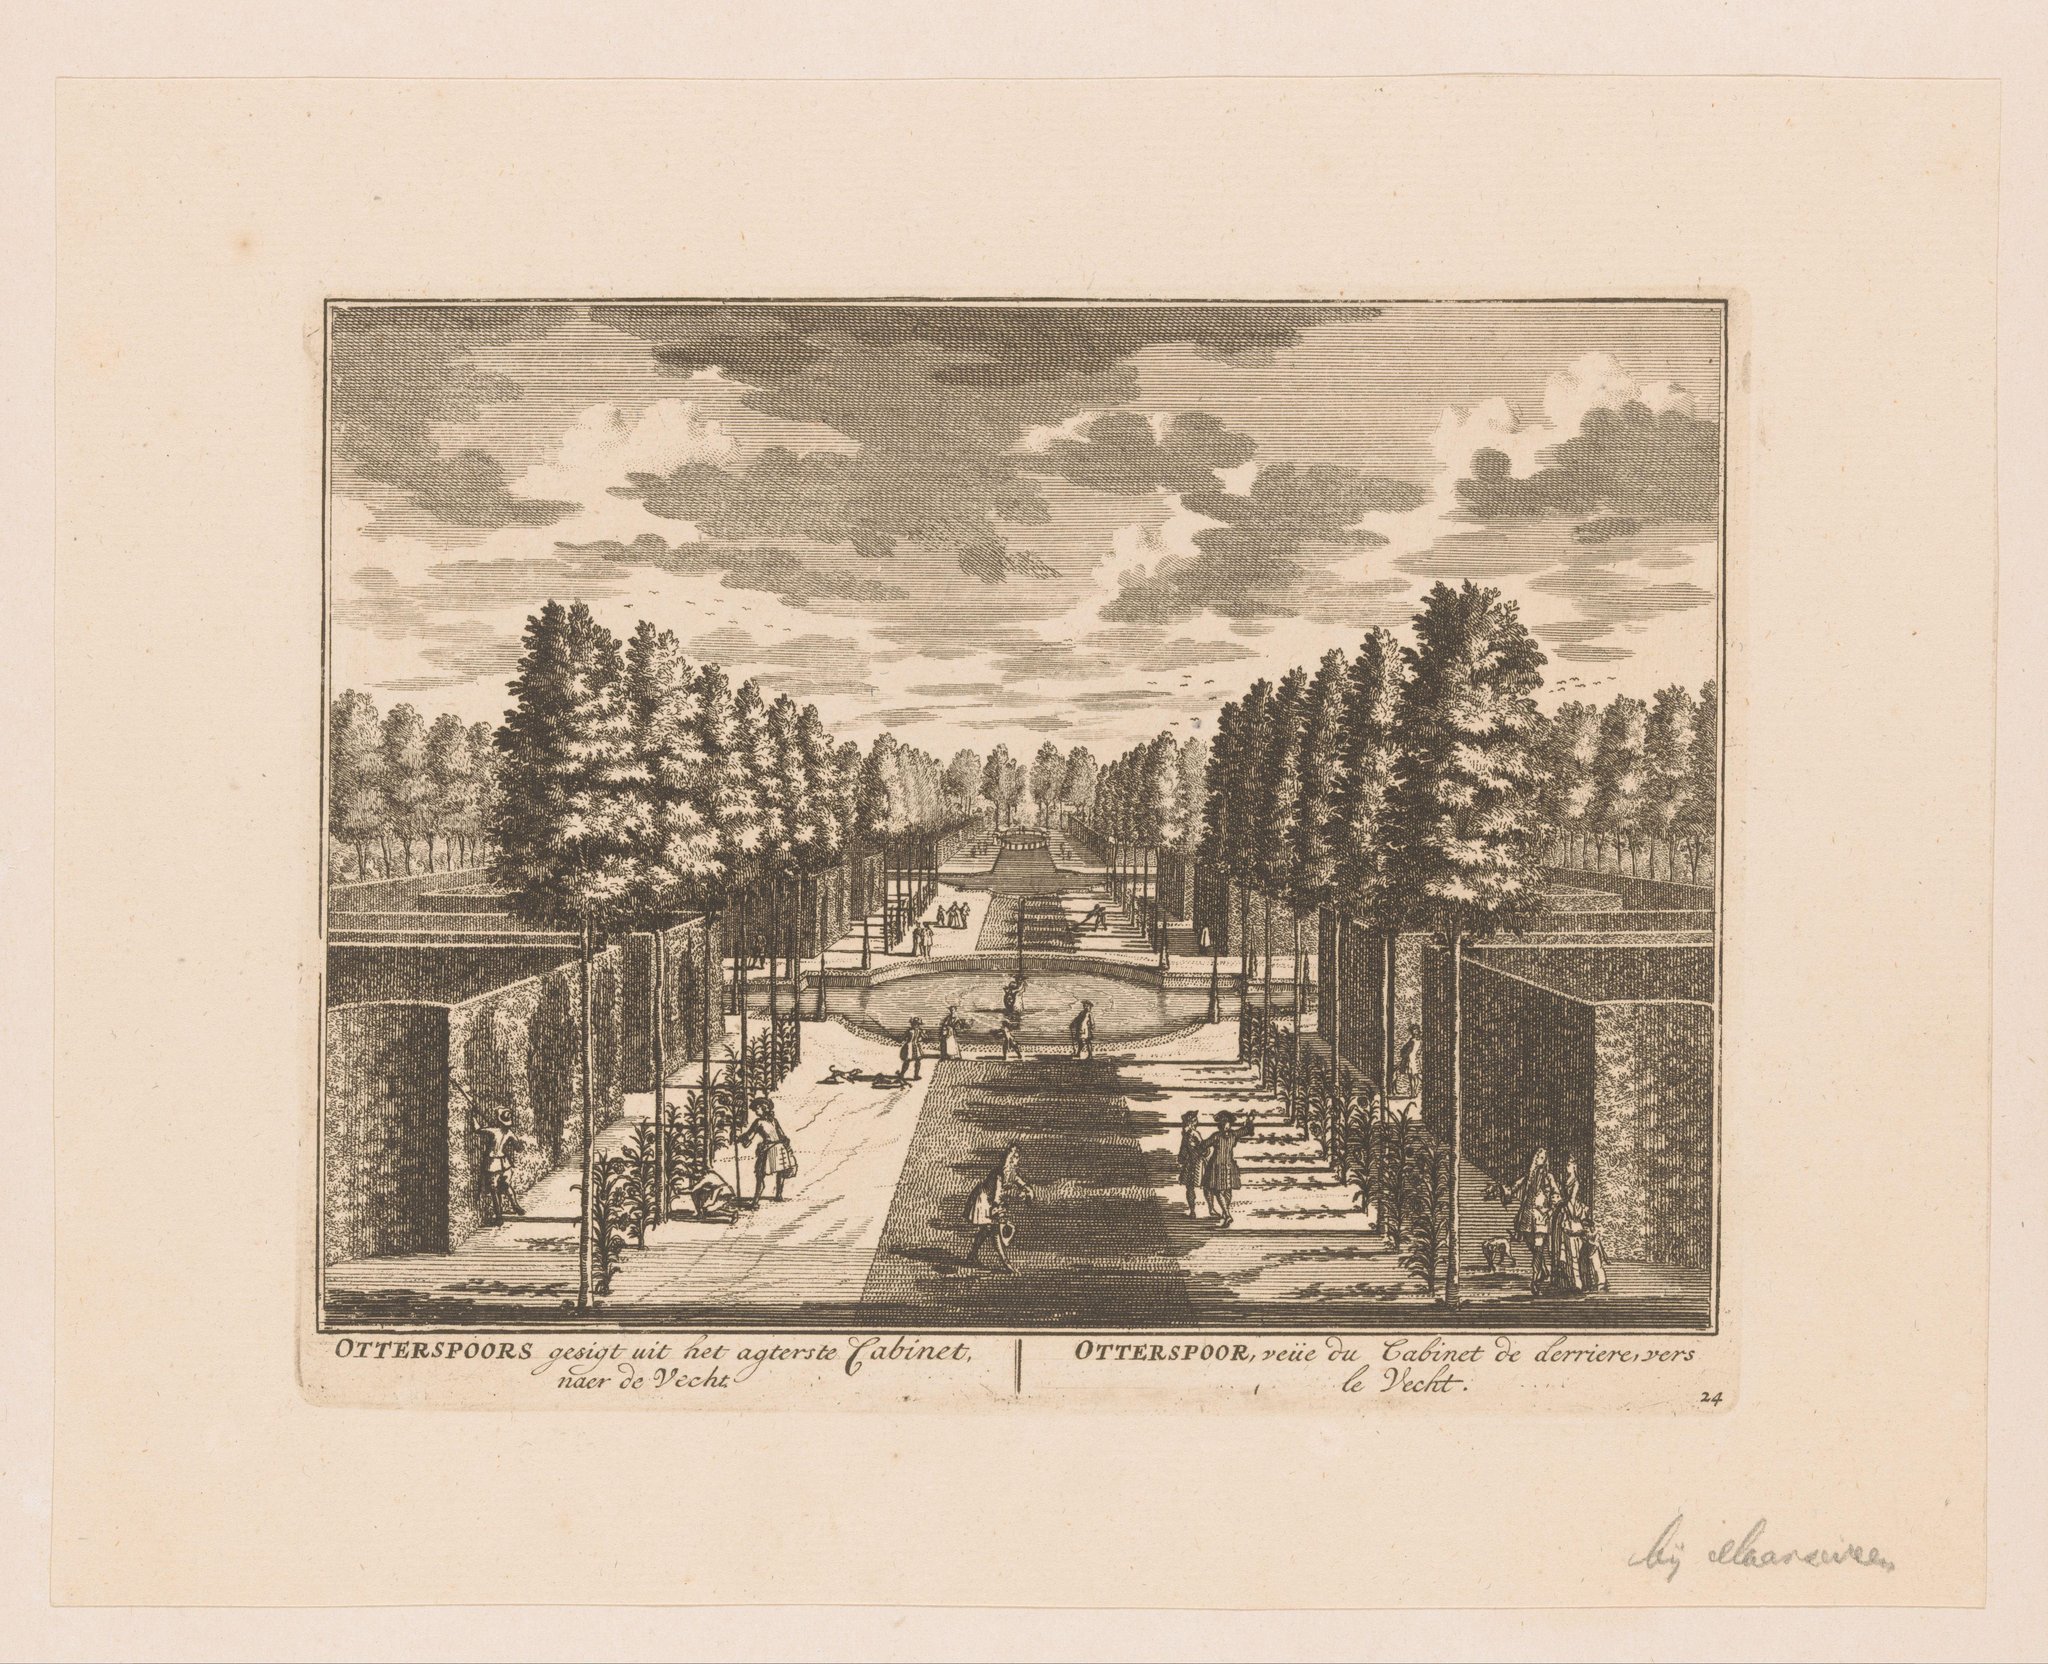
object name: print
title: Otterspoors gesigt uit het agterste cabinet, naer de Vecht / Otterspoor, veüe du cabinet de derriere vers le Vecht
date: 1719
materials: paper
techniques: engraving, etching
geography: amsterdam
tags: french or architectonic garden; formal garden, garden pond, maarssen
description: Prent uit: Leth, Andries de. De Zegepraalende Vecht (...). Amsterdam: Weduwe Nicolaes Visscher, 1719, pl. 24. Later ook uitgegeven in: Brouërius van Nidek, Matthaeus. De Vechtstroom, van Utrecht tot Muiden (...). Amsterdam: H. Gartman, W. Vermandel en J.W. Smit, 1790.